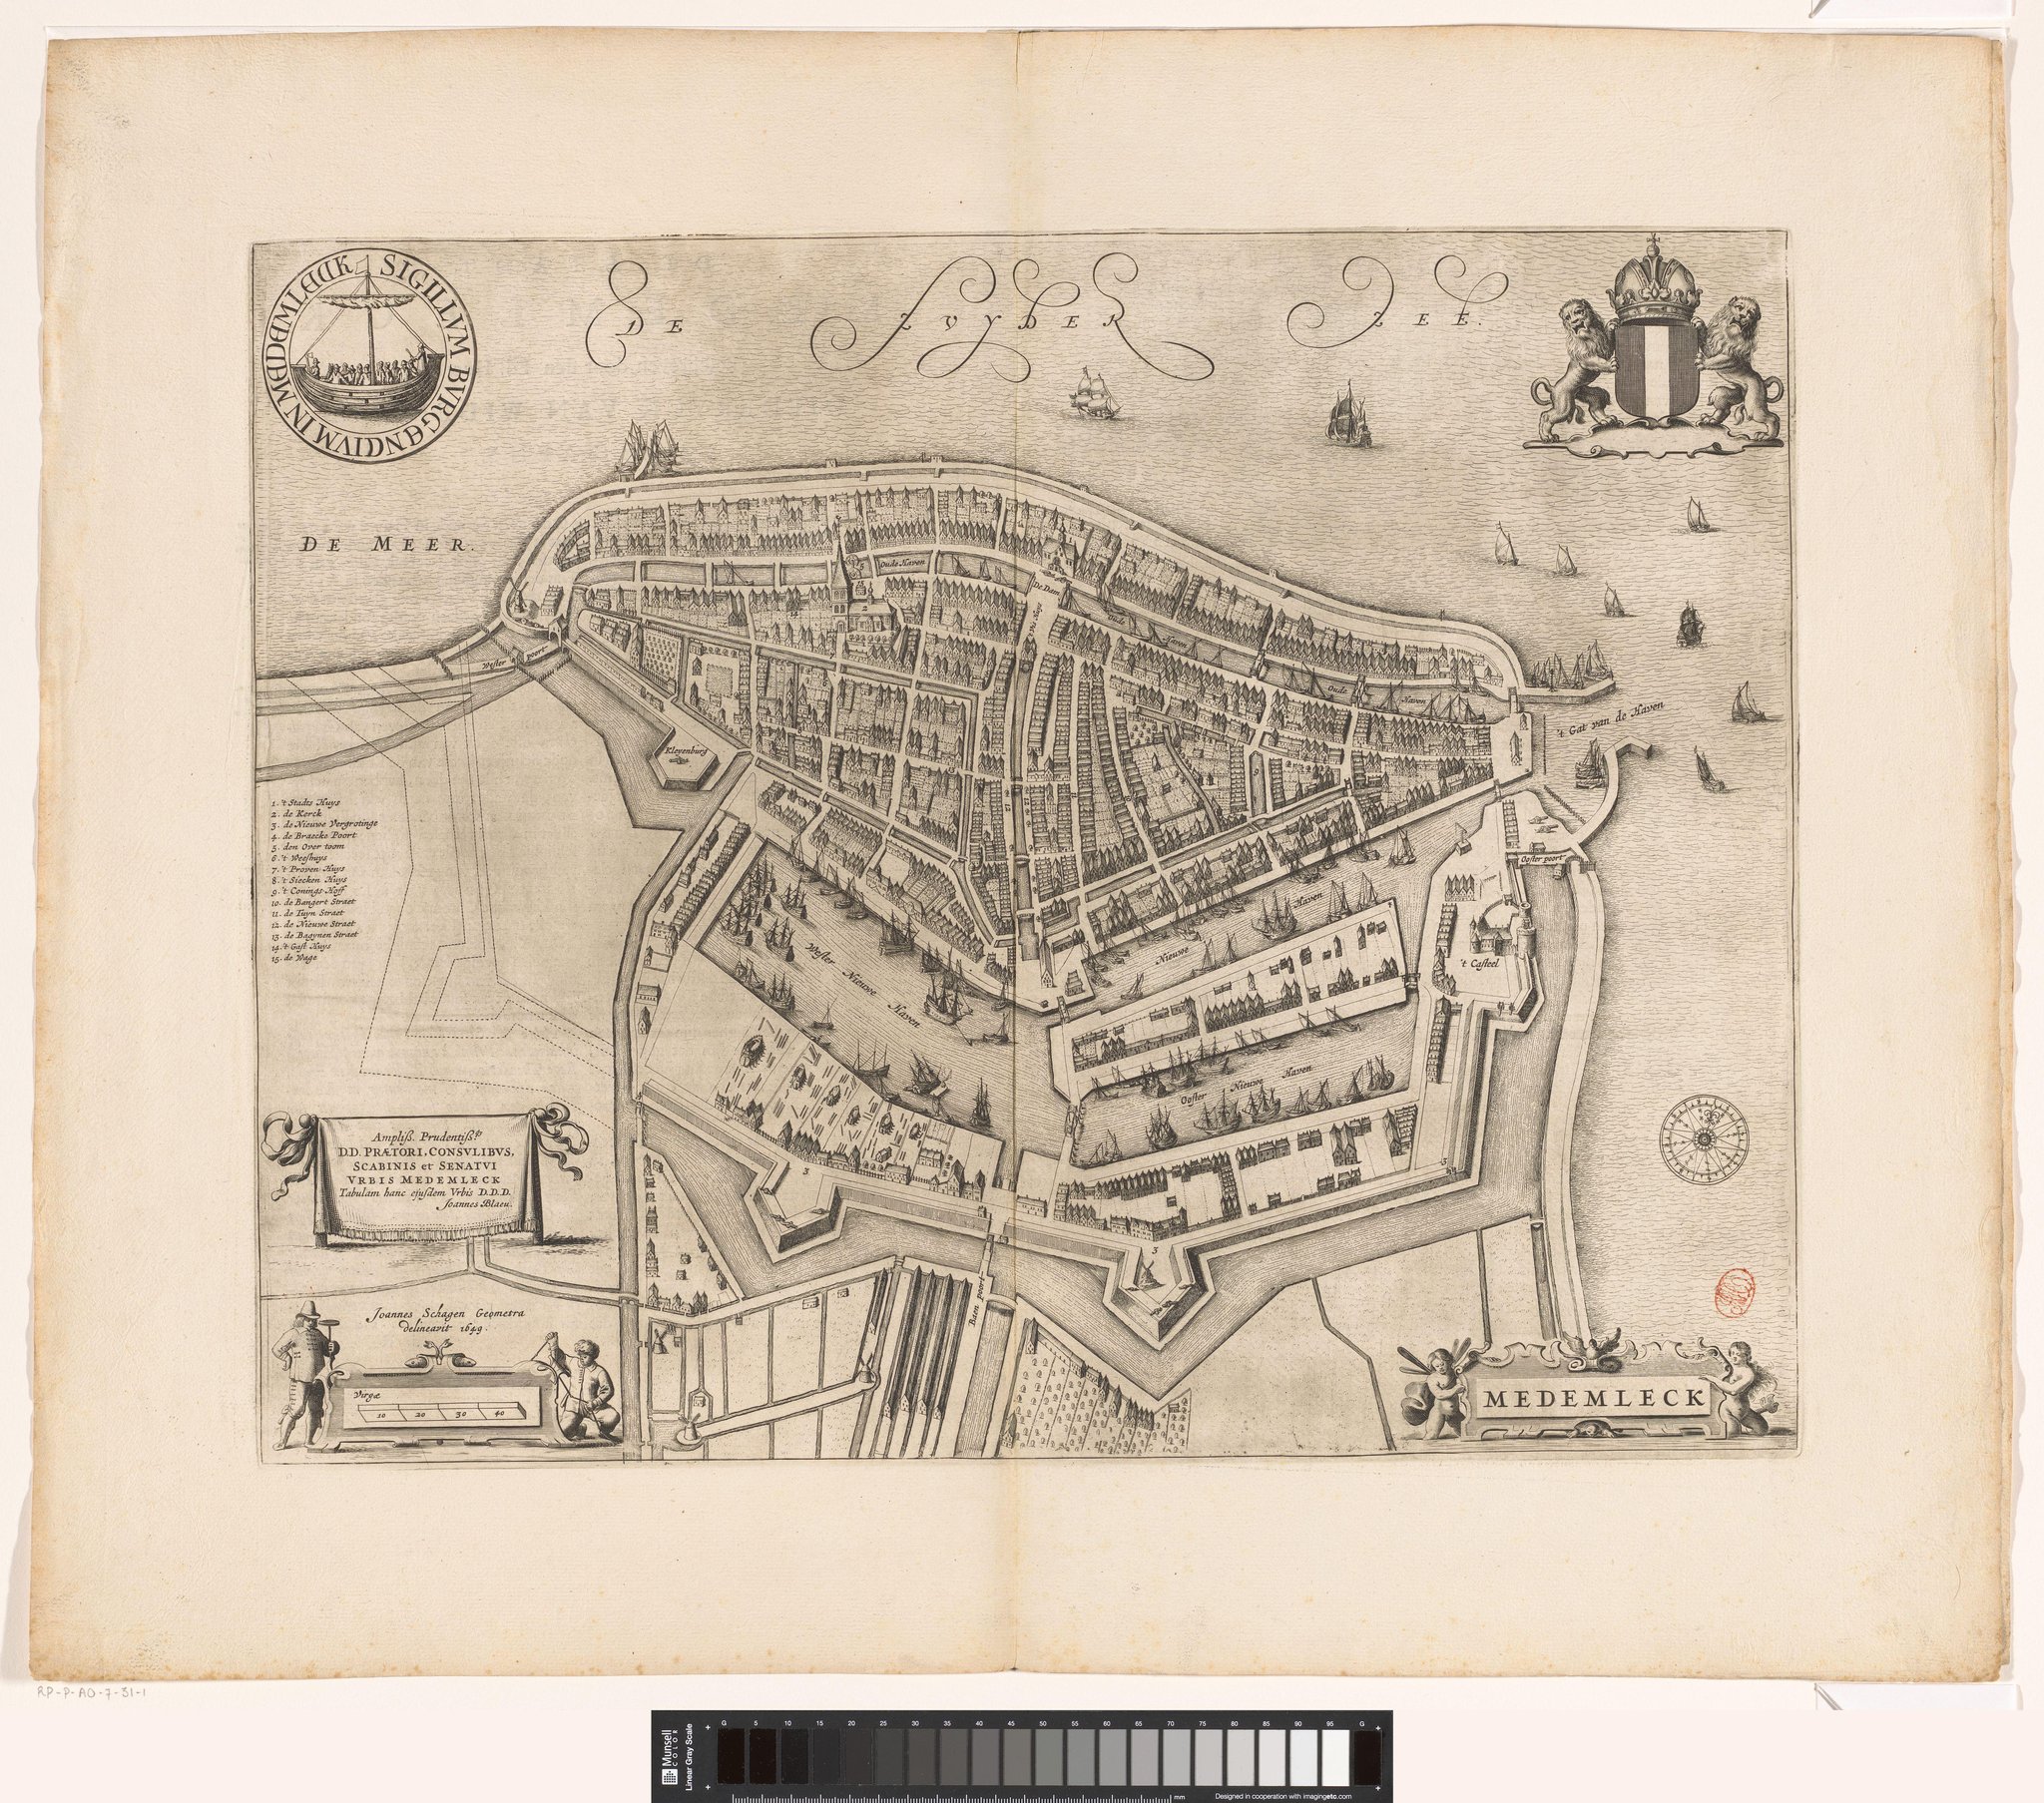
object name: area plan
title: Plattegrond van Medemblik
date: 1652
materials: paper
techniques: engraving, etching, letterpress printing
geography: amsterdam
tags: coat of arms (as symbol of the state, etc.) (+ city; municipal), geodesy, surveying, maps of cities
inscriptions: collector's mark: Lugt 195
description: Plattegrond in vogelvluchtperspectief. Linksboven het stadszegel van Medemblik, rechtsboven het stadswapen. Links een legenda, linksonder een cartouche met de opdracht en daaronder een cartouche met een schaalstok: Virge. Links en rechts van de schaalstok een landmeter. Rechtsonder de titelcartouche. Op verso Nederlandse tekst.